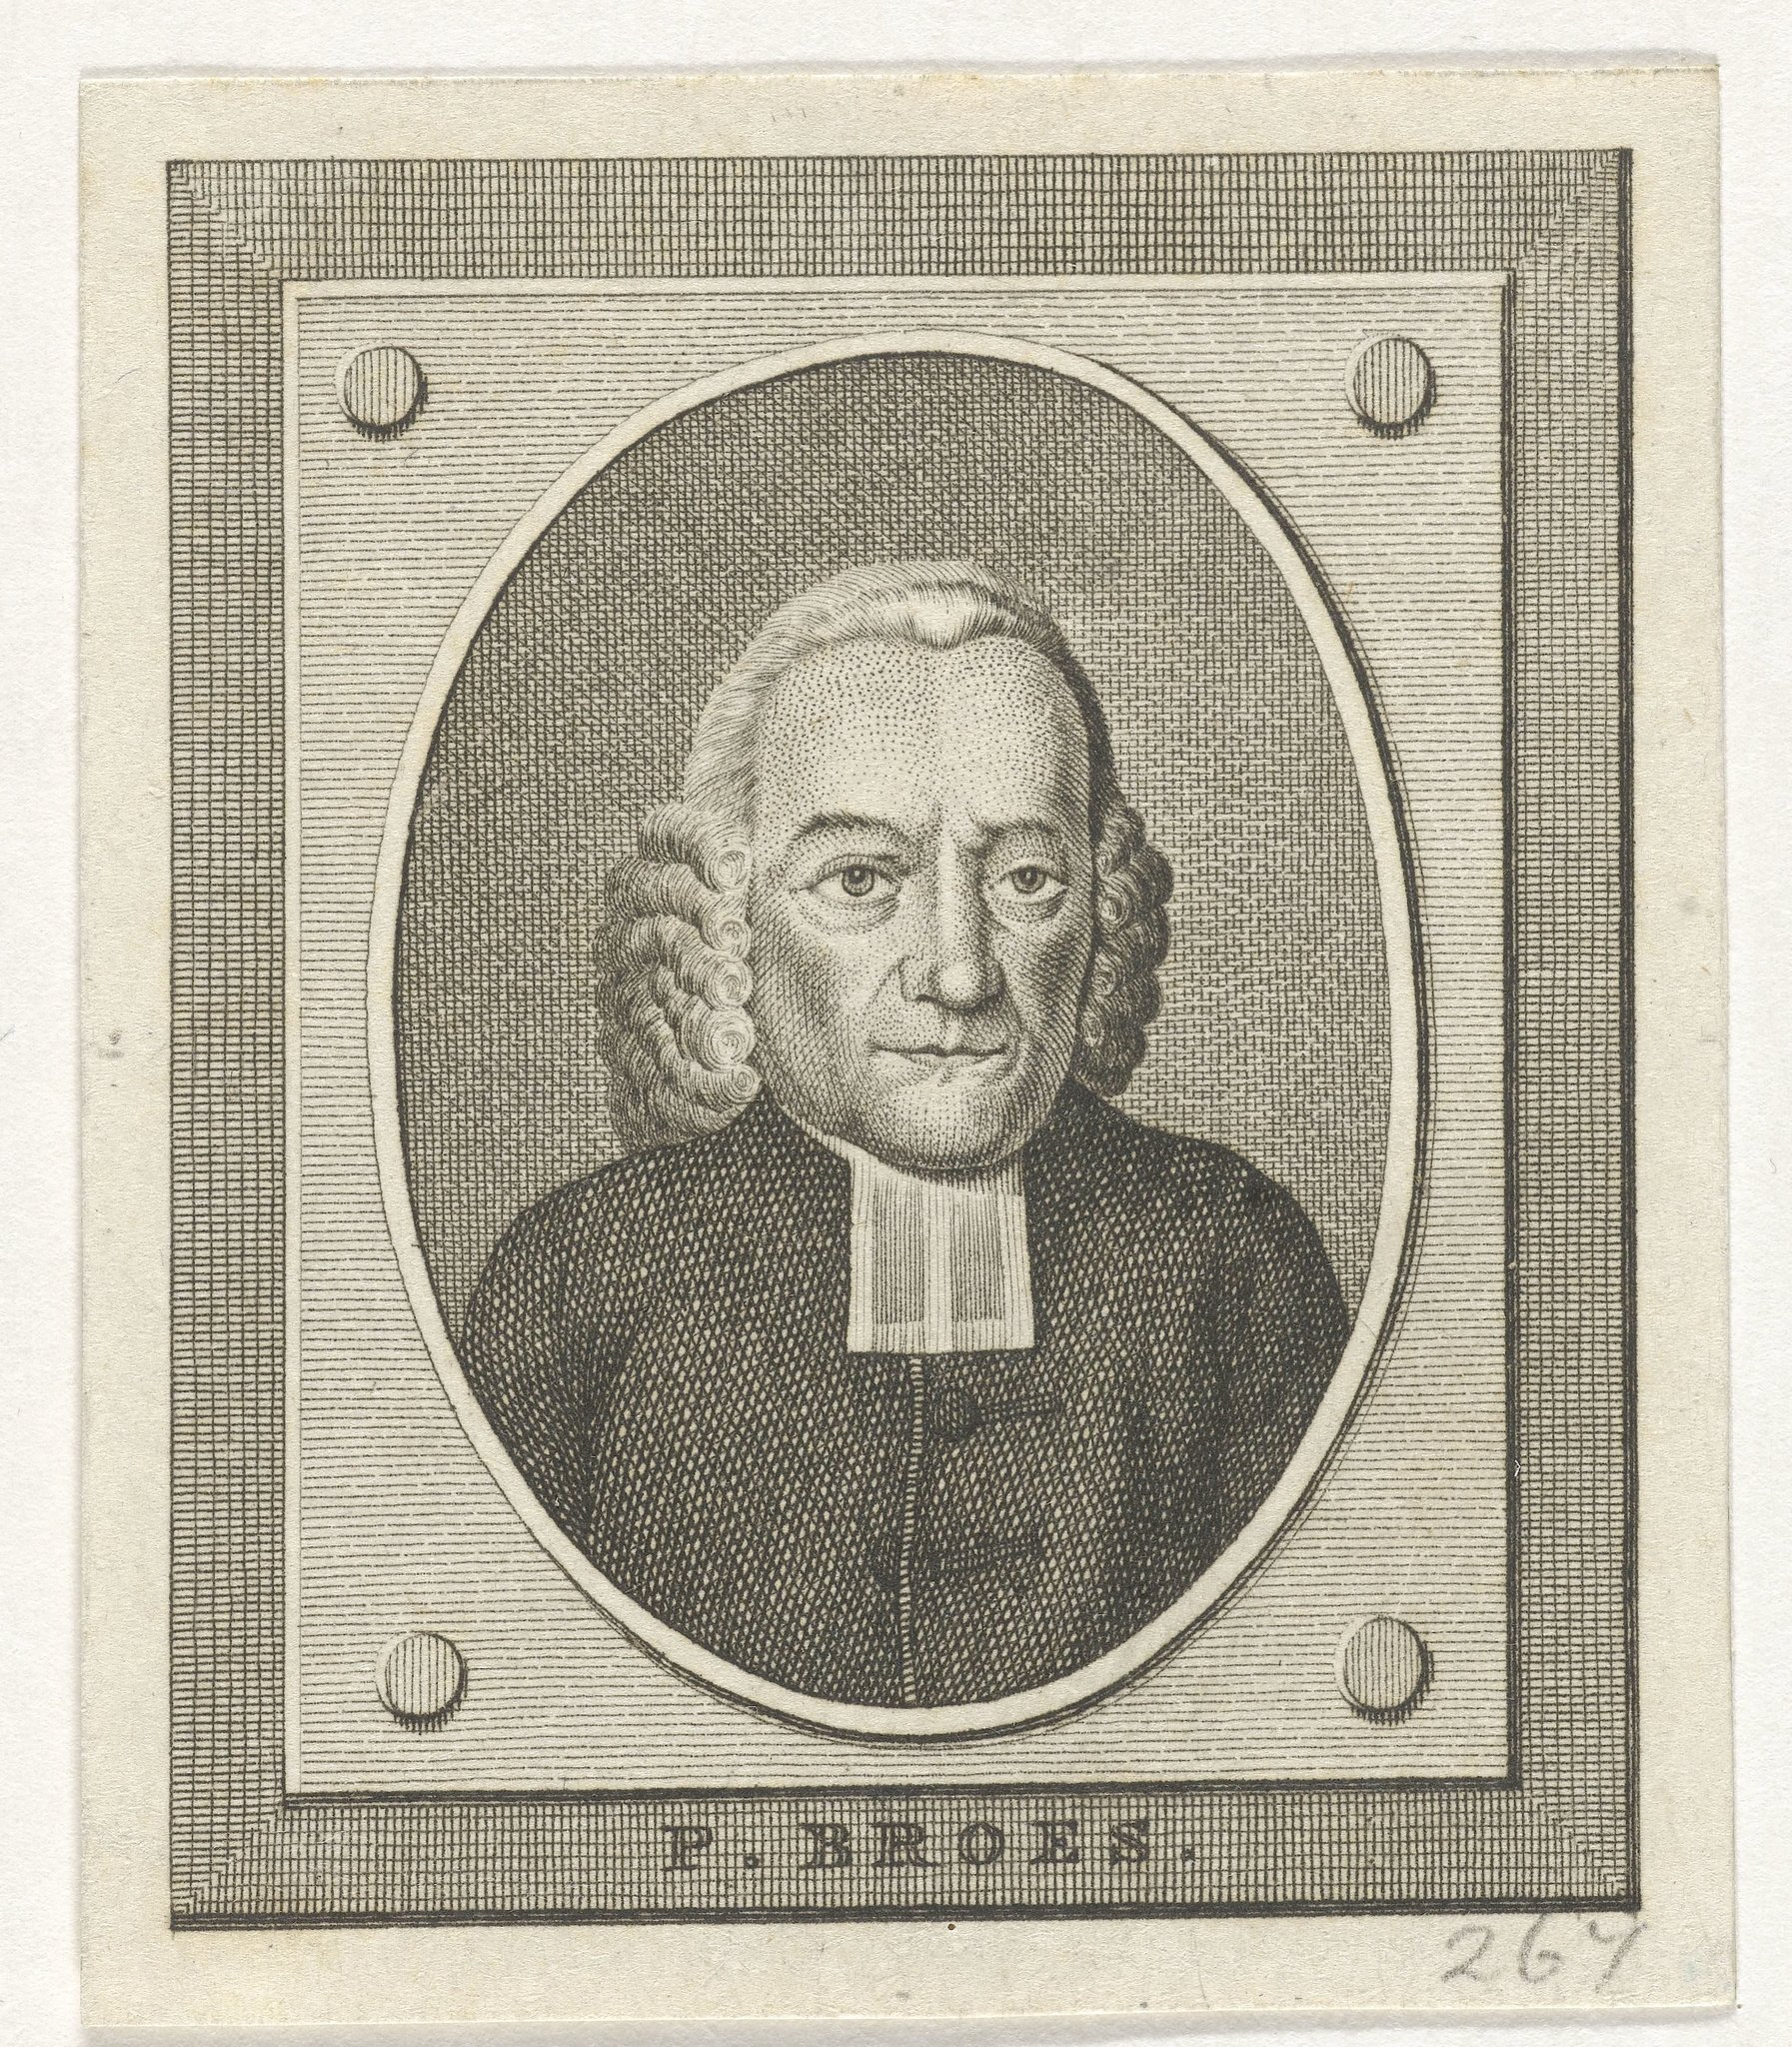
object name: print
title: Portret van Petrus Broes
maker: carel jacob de huyser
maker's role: print maker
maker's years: 1743-1804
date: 1763-1804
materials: paper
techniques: engraving, etching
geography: amsterdam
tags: petrus broes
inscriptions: collector's mark: Lugt 2228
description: Busteportret van Petrus Broes en face in een ovale lijst.